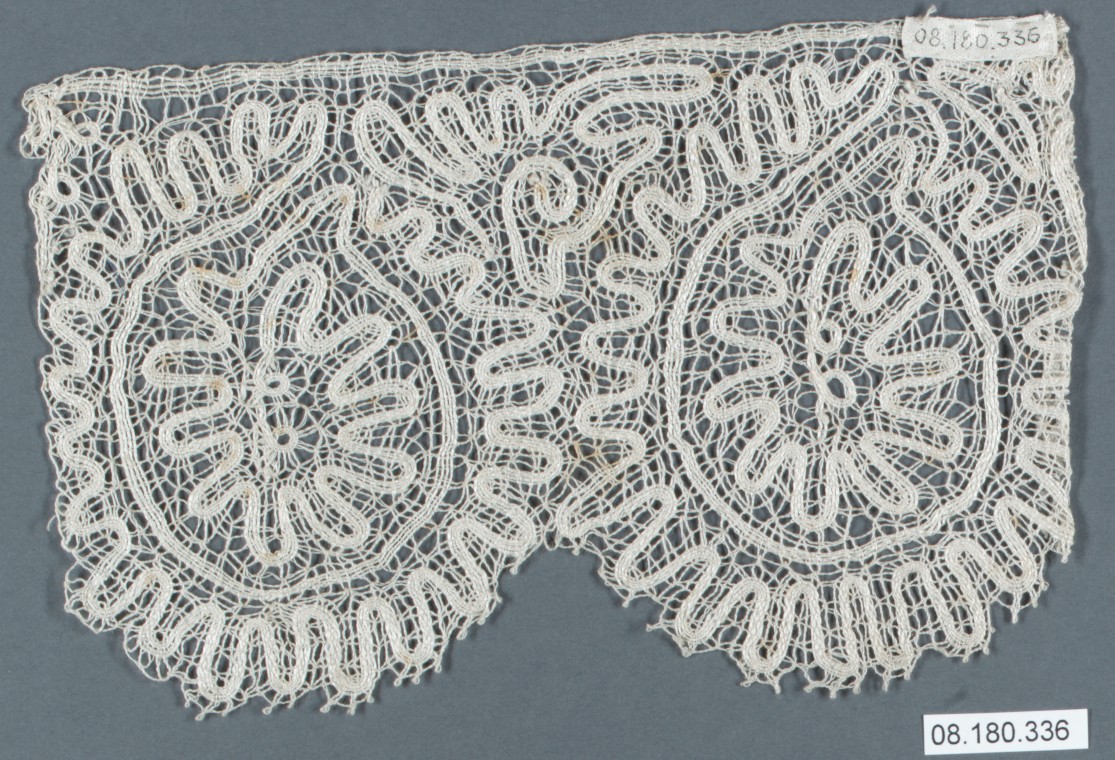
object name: piece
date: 1801-1900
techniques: lace